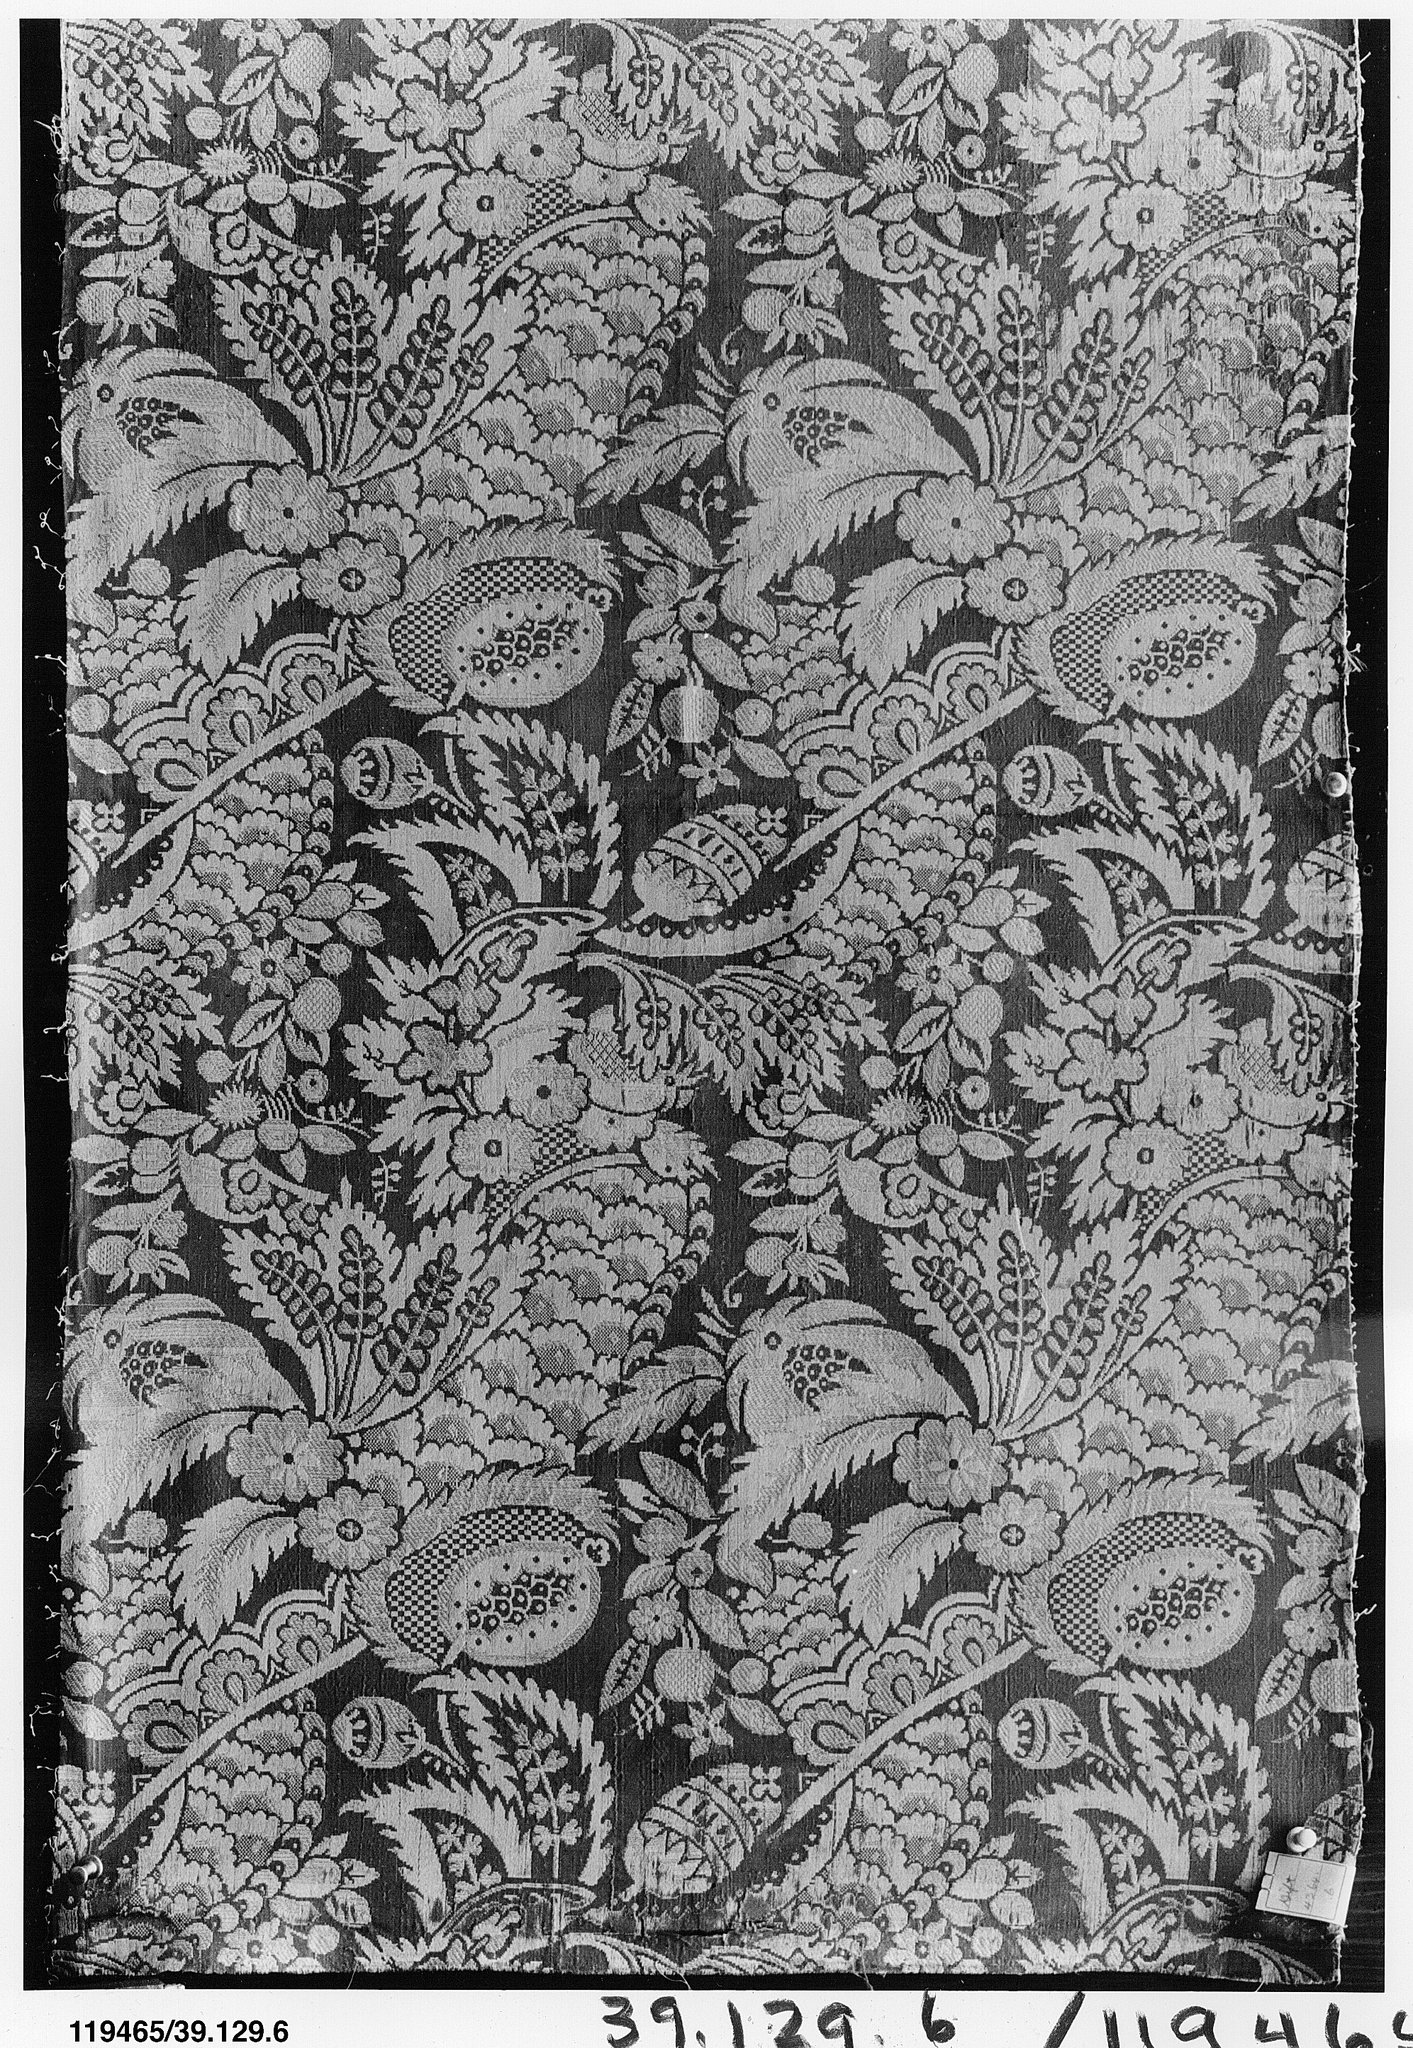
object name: piece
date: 1720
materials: silk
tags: flowers,leaves